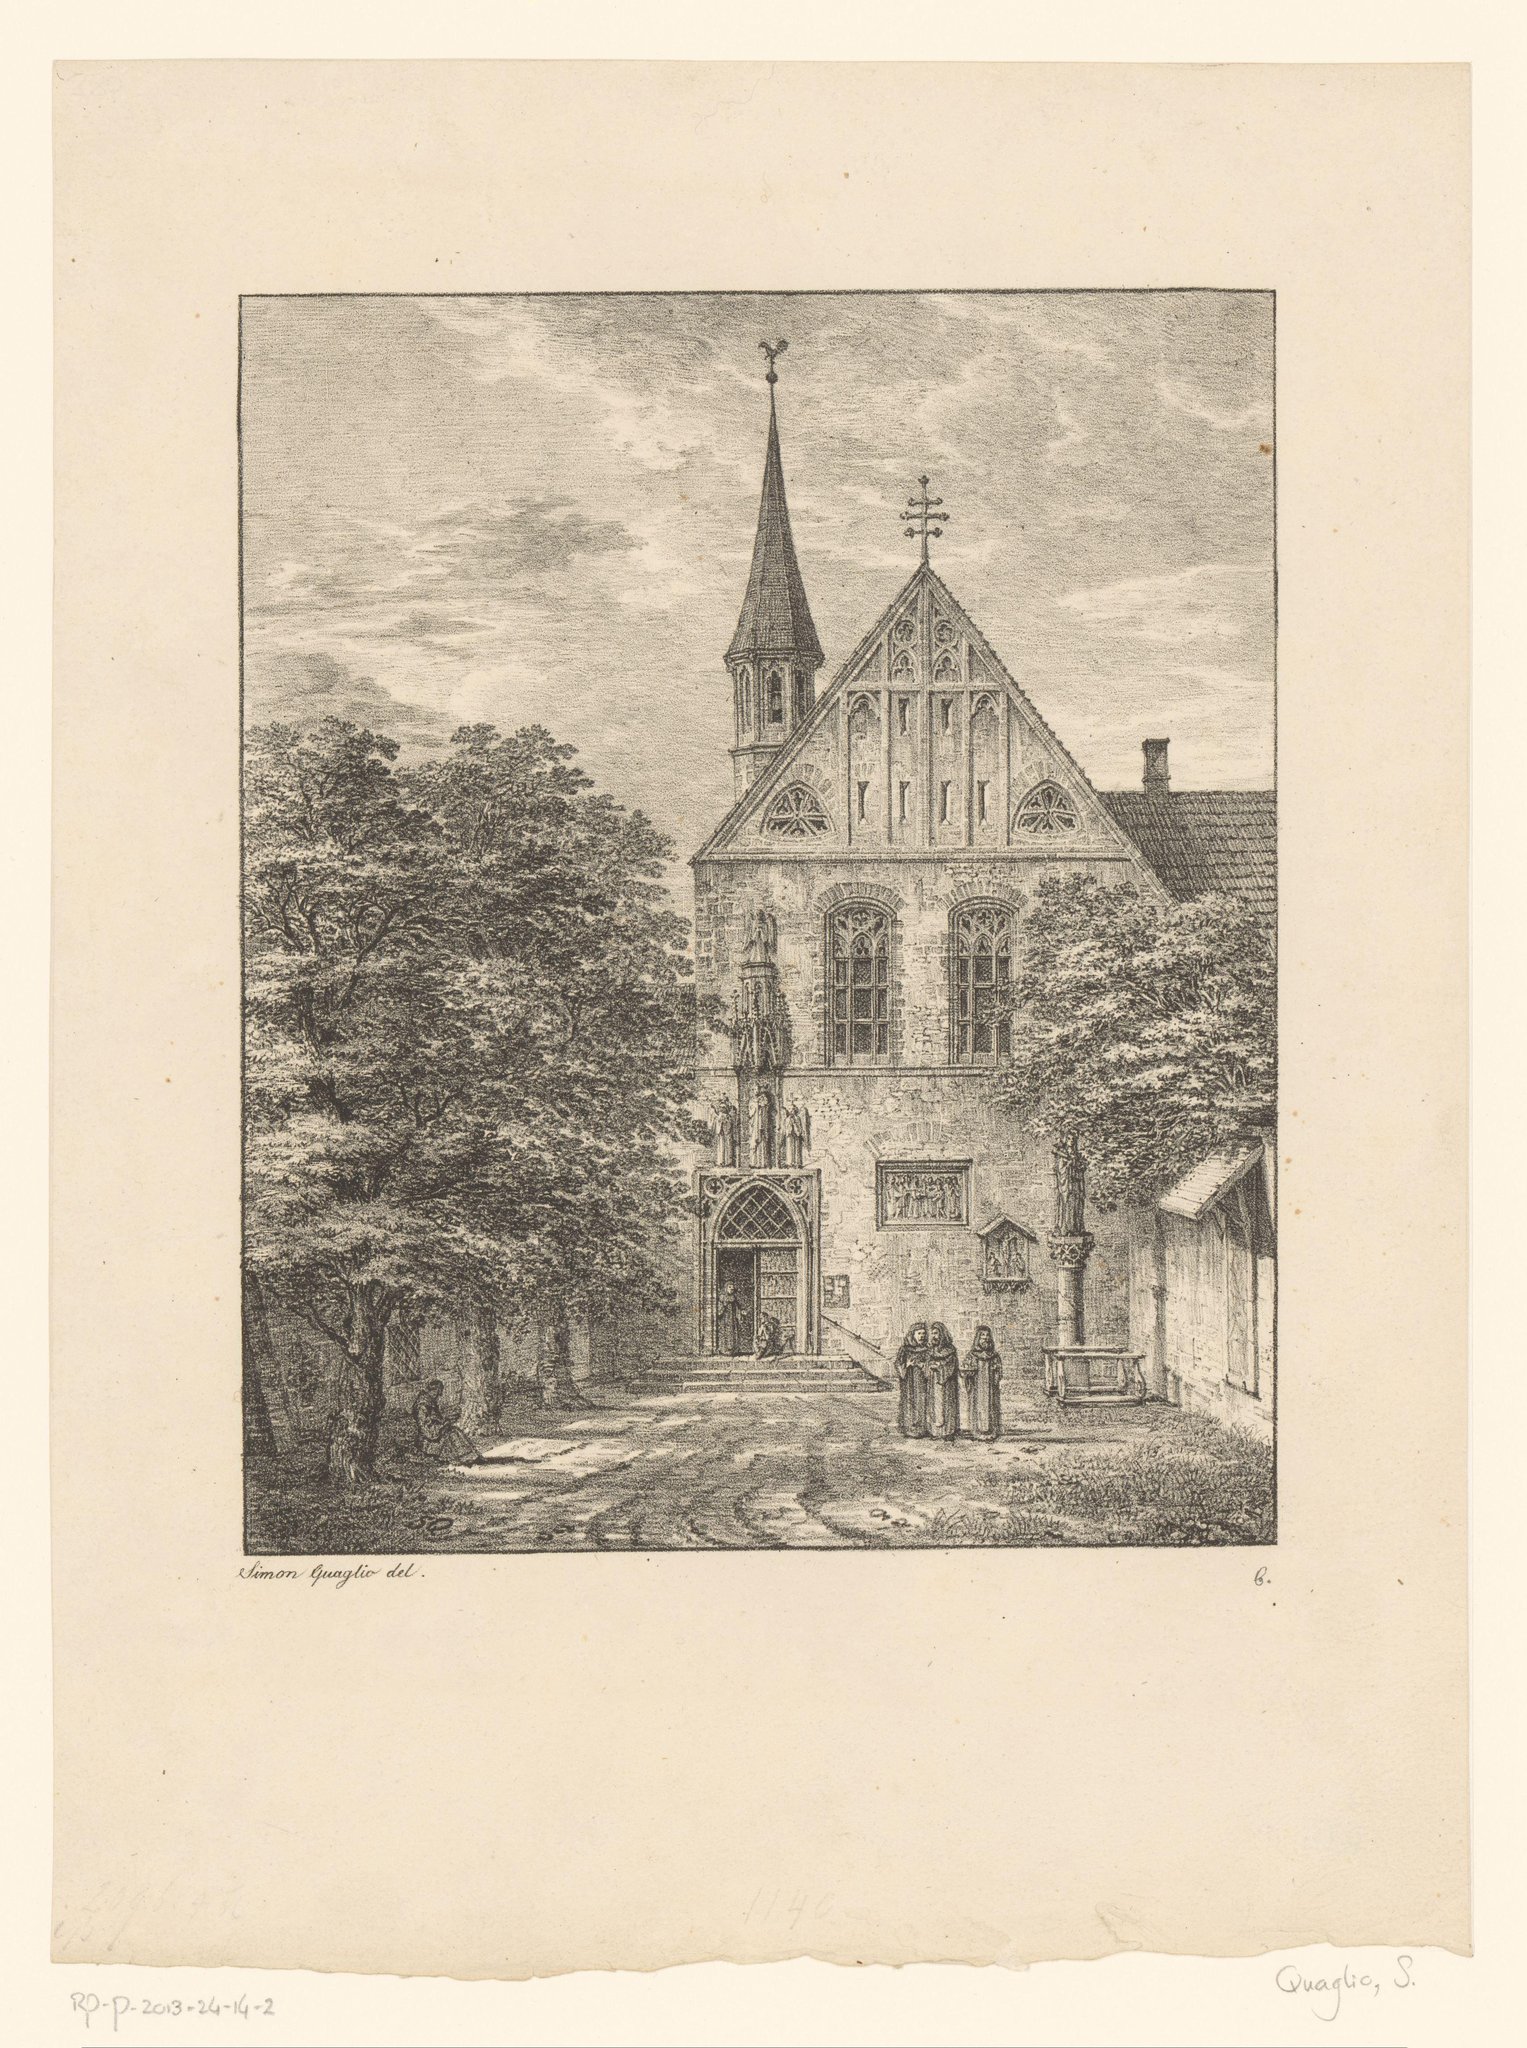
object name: print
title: Gezicht op een gotisch klooster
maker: simon quaglio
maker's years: 1795-1878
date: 1805-1878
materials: paper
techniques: lithograph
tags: abbey, monastery, convent ~ roman catholic church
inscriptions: collector's mark: Lugt 3976, collector's mark: Lugt 2228, collector's mark: Lugt 2760